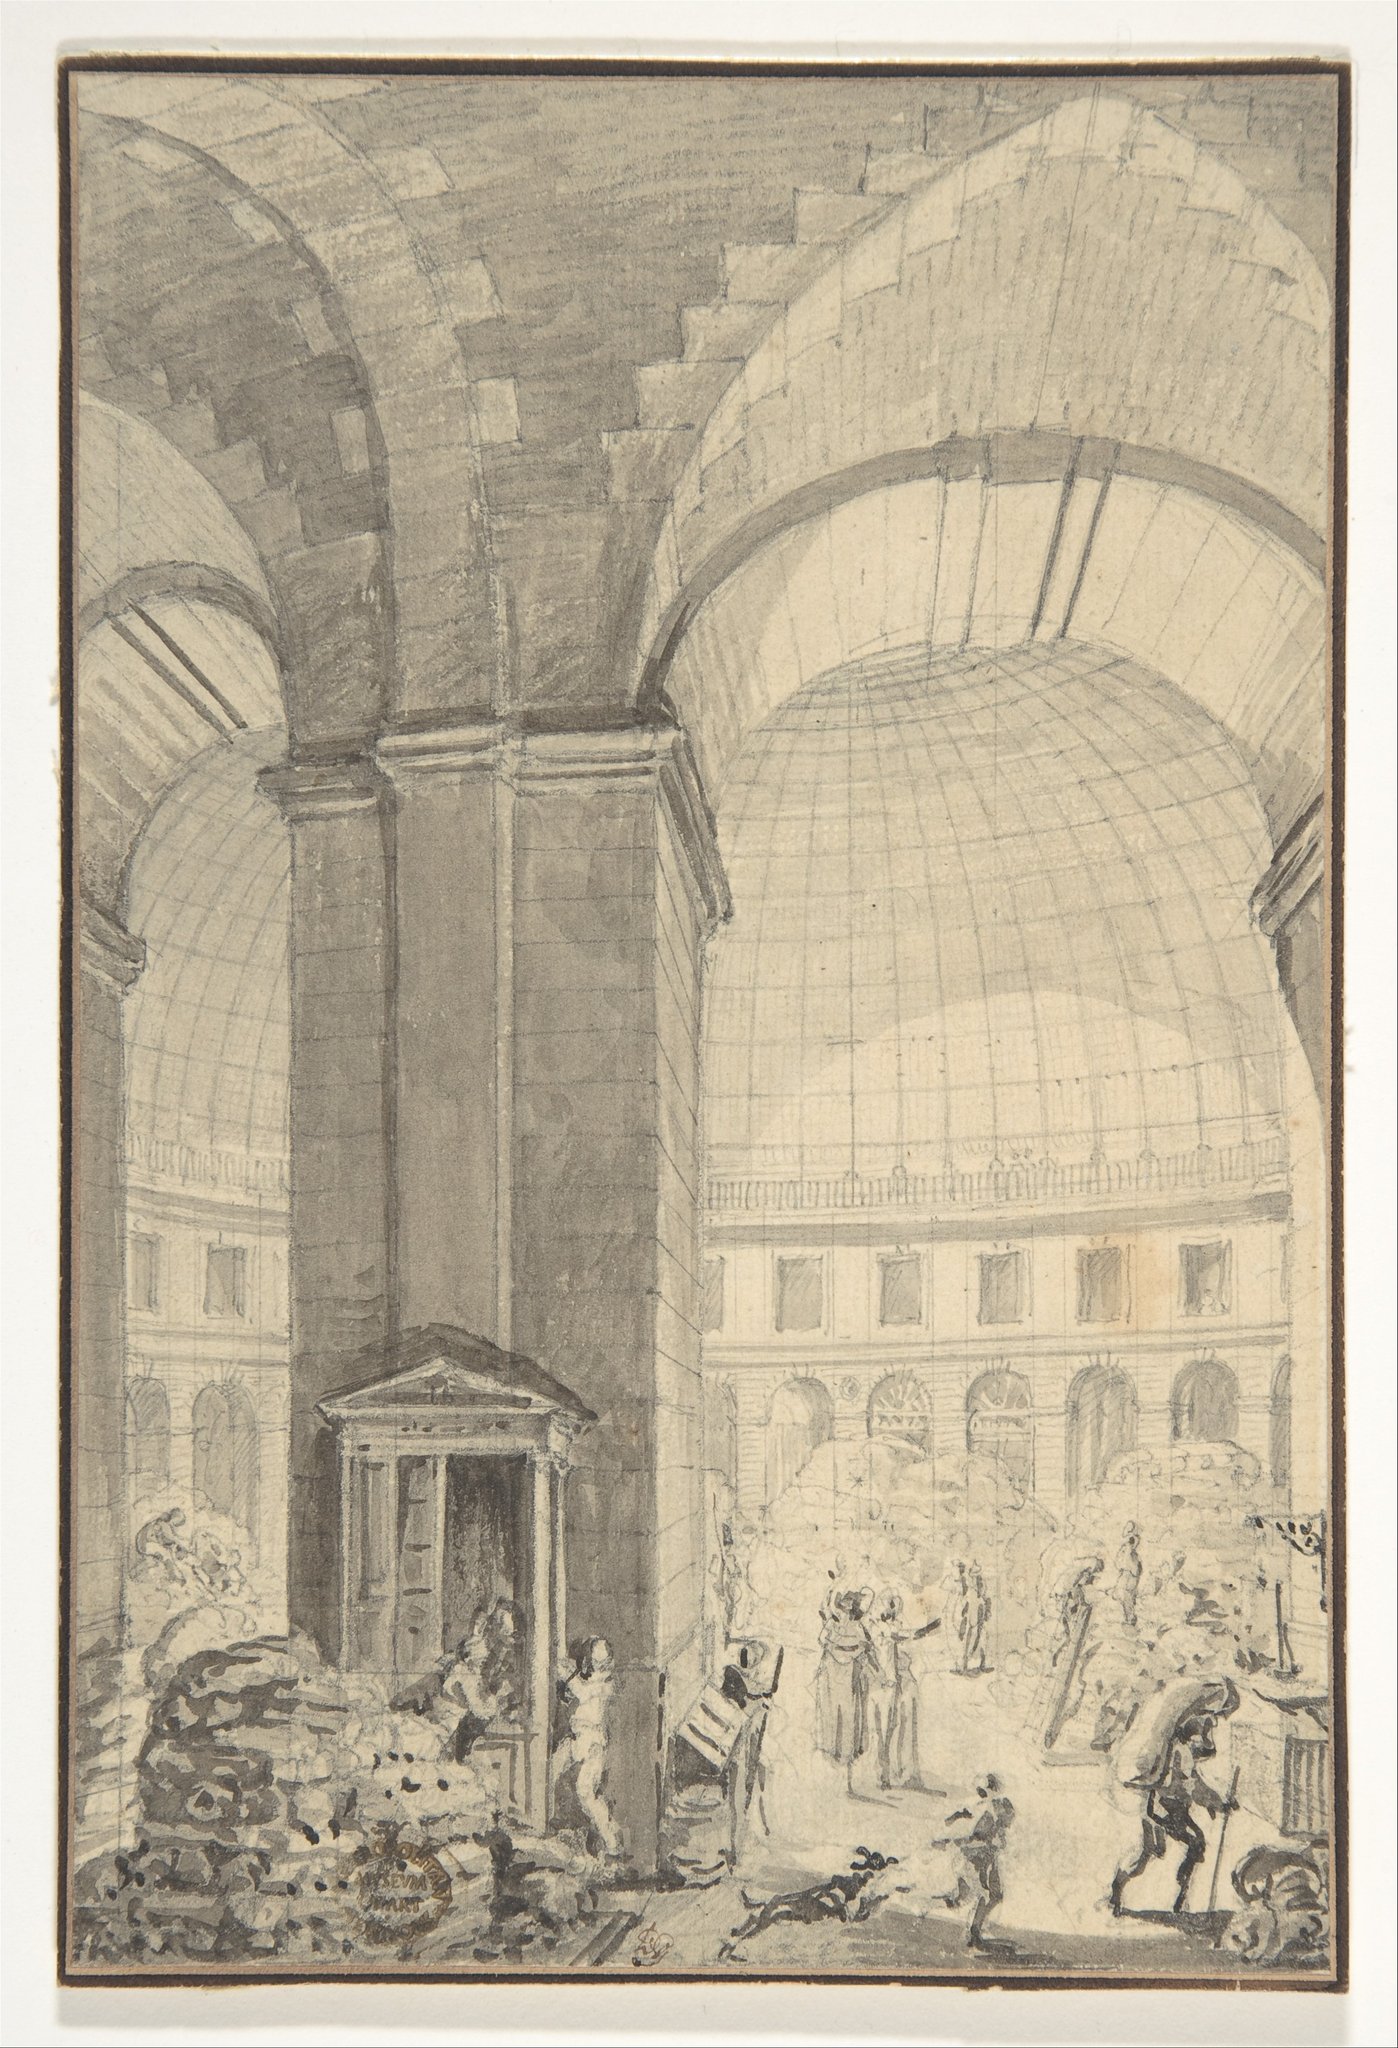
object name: drawing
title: Interior of Halle aux Blés, Paris [The Corn Exchange]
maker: jean démosthène dugourc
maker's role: designer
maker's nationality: french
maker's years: 1749-1825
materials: graphite, ink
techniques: pen, wash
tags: interiors,men,women,dogs,paris